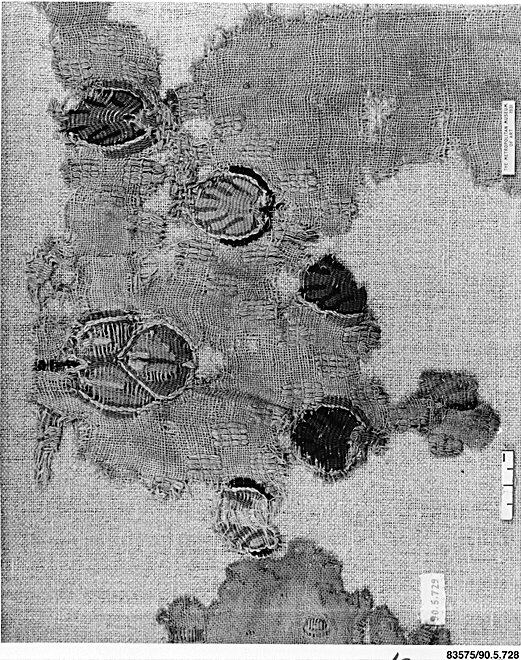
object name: textile fragment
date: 401-600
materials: linen, wool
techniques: weave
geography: egypt